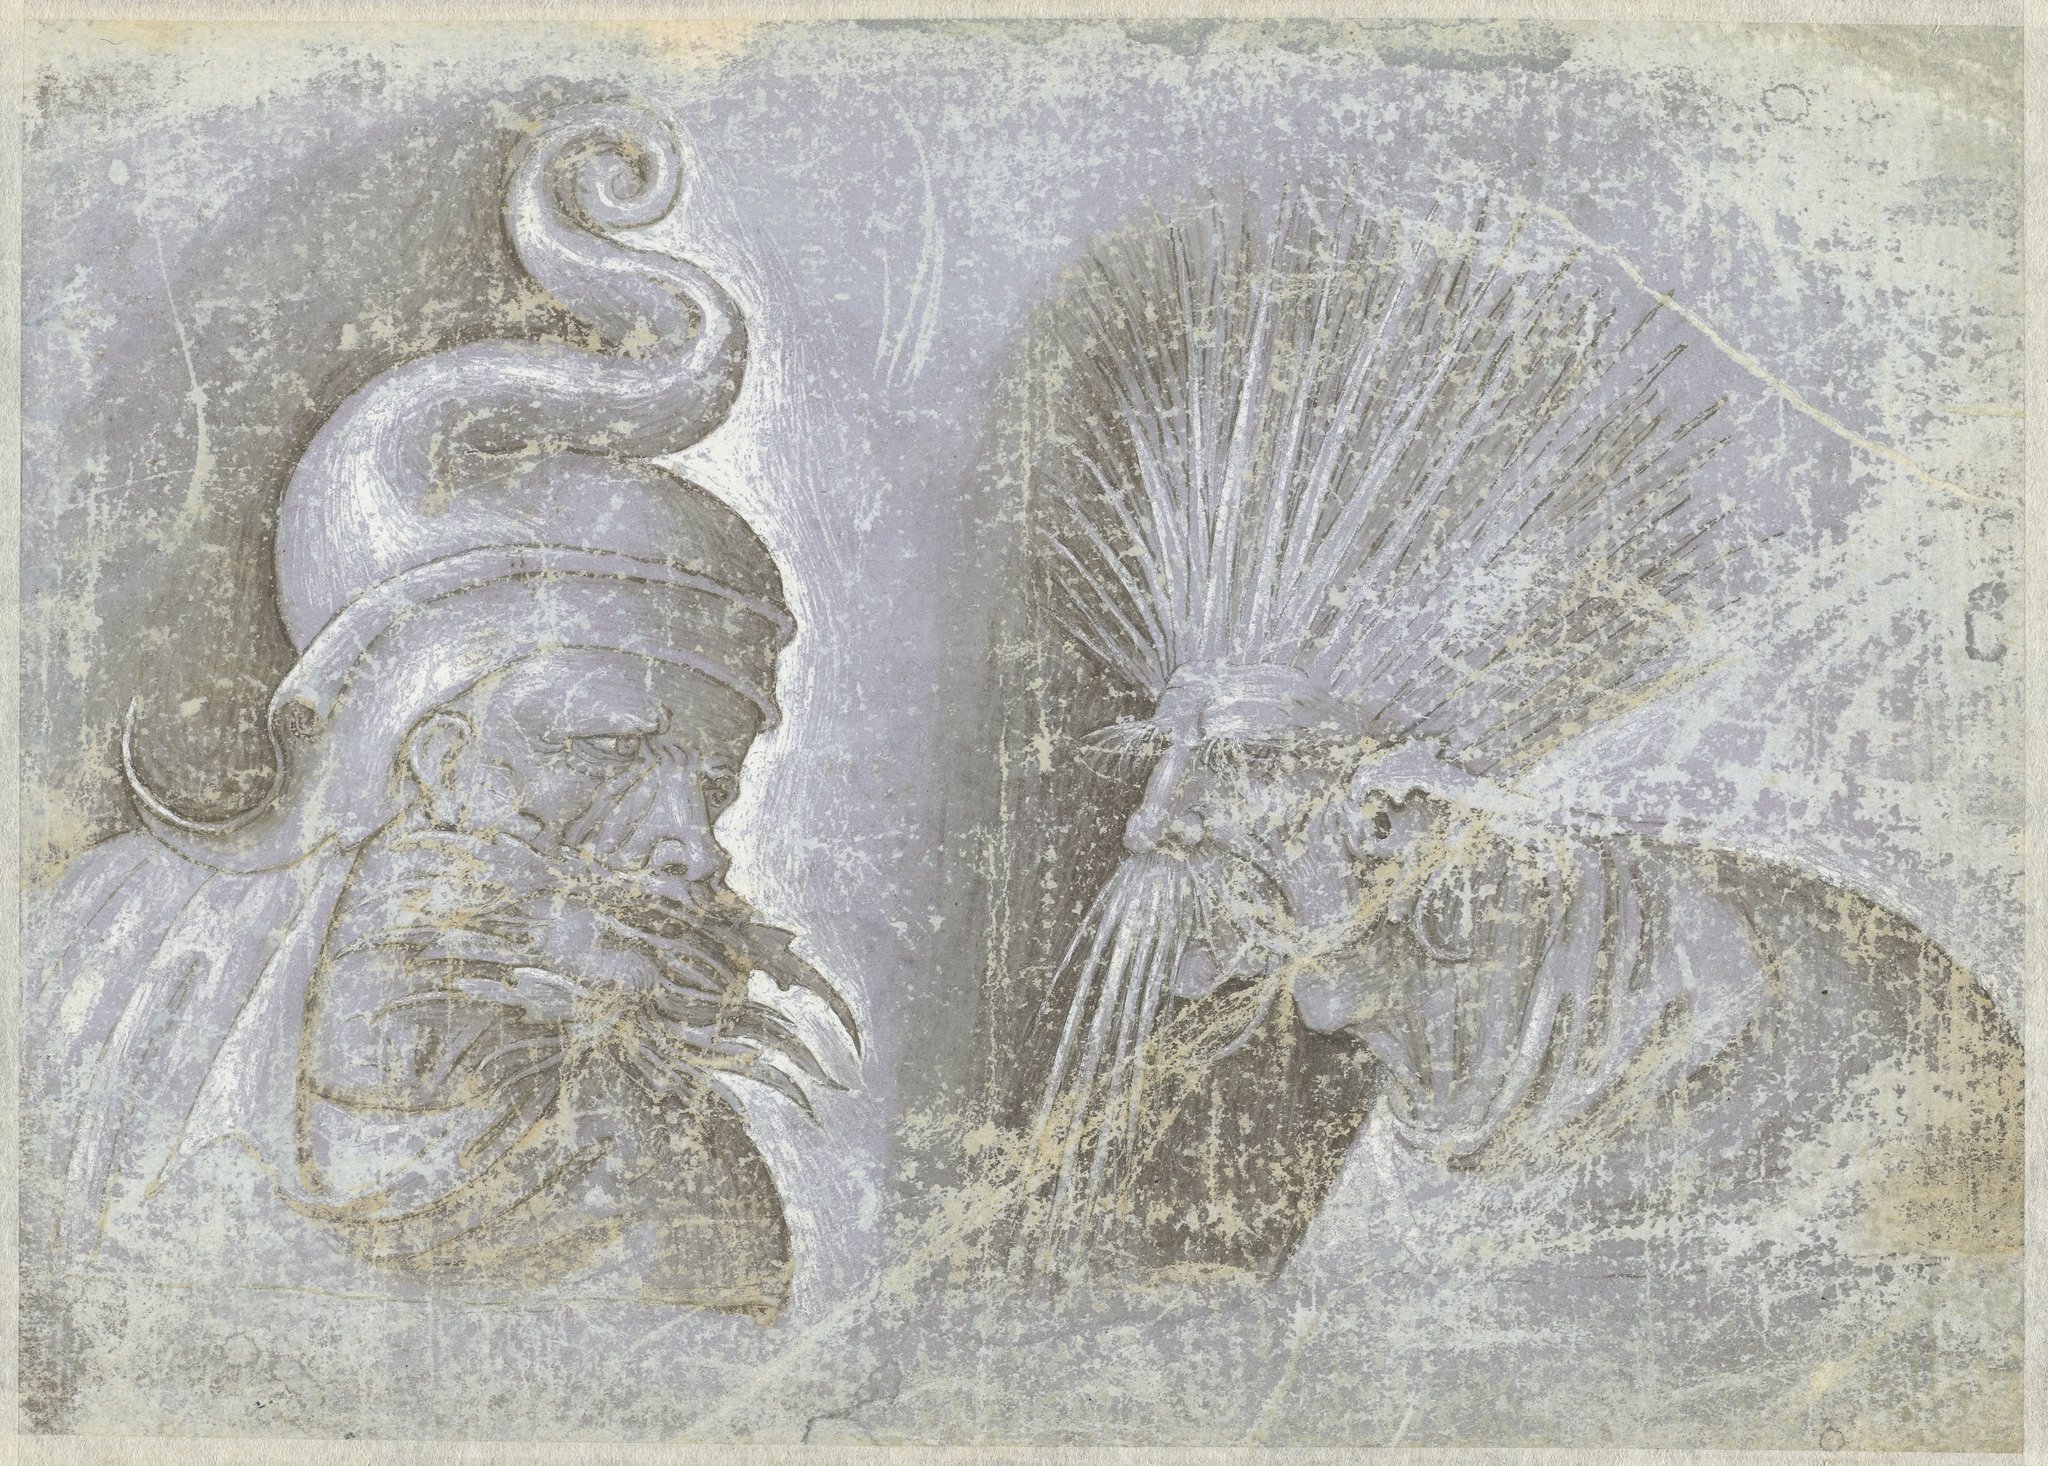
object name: drawing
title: Hoofden van mannen met uitheemse hoofddeksels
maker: jacopo ripanda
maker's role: draughtsman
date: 1500-1525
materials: ink, paper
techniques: brush, pen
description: Blad uit serie met hoofden van mannen met uitheemse hoofddeksels op blauw en paars geprepareerd papier.